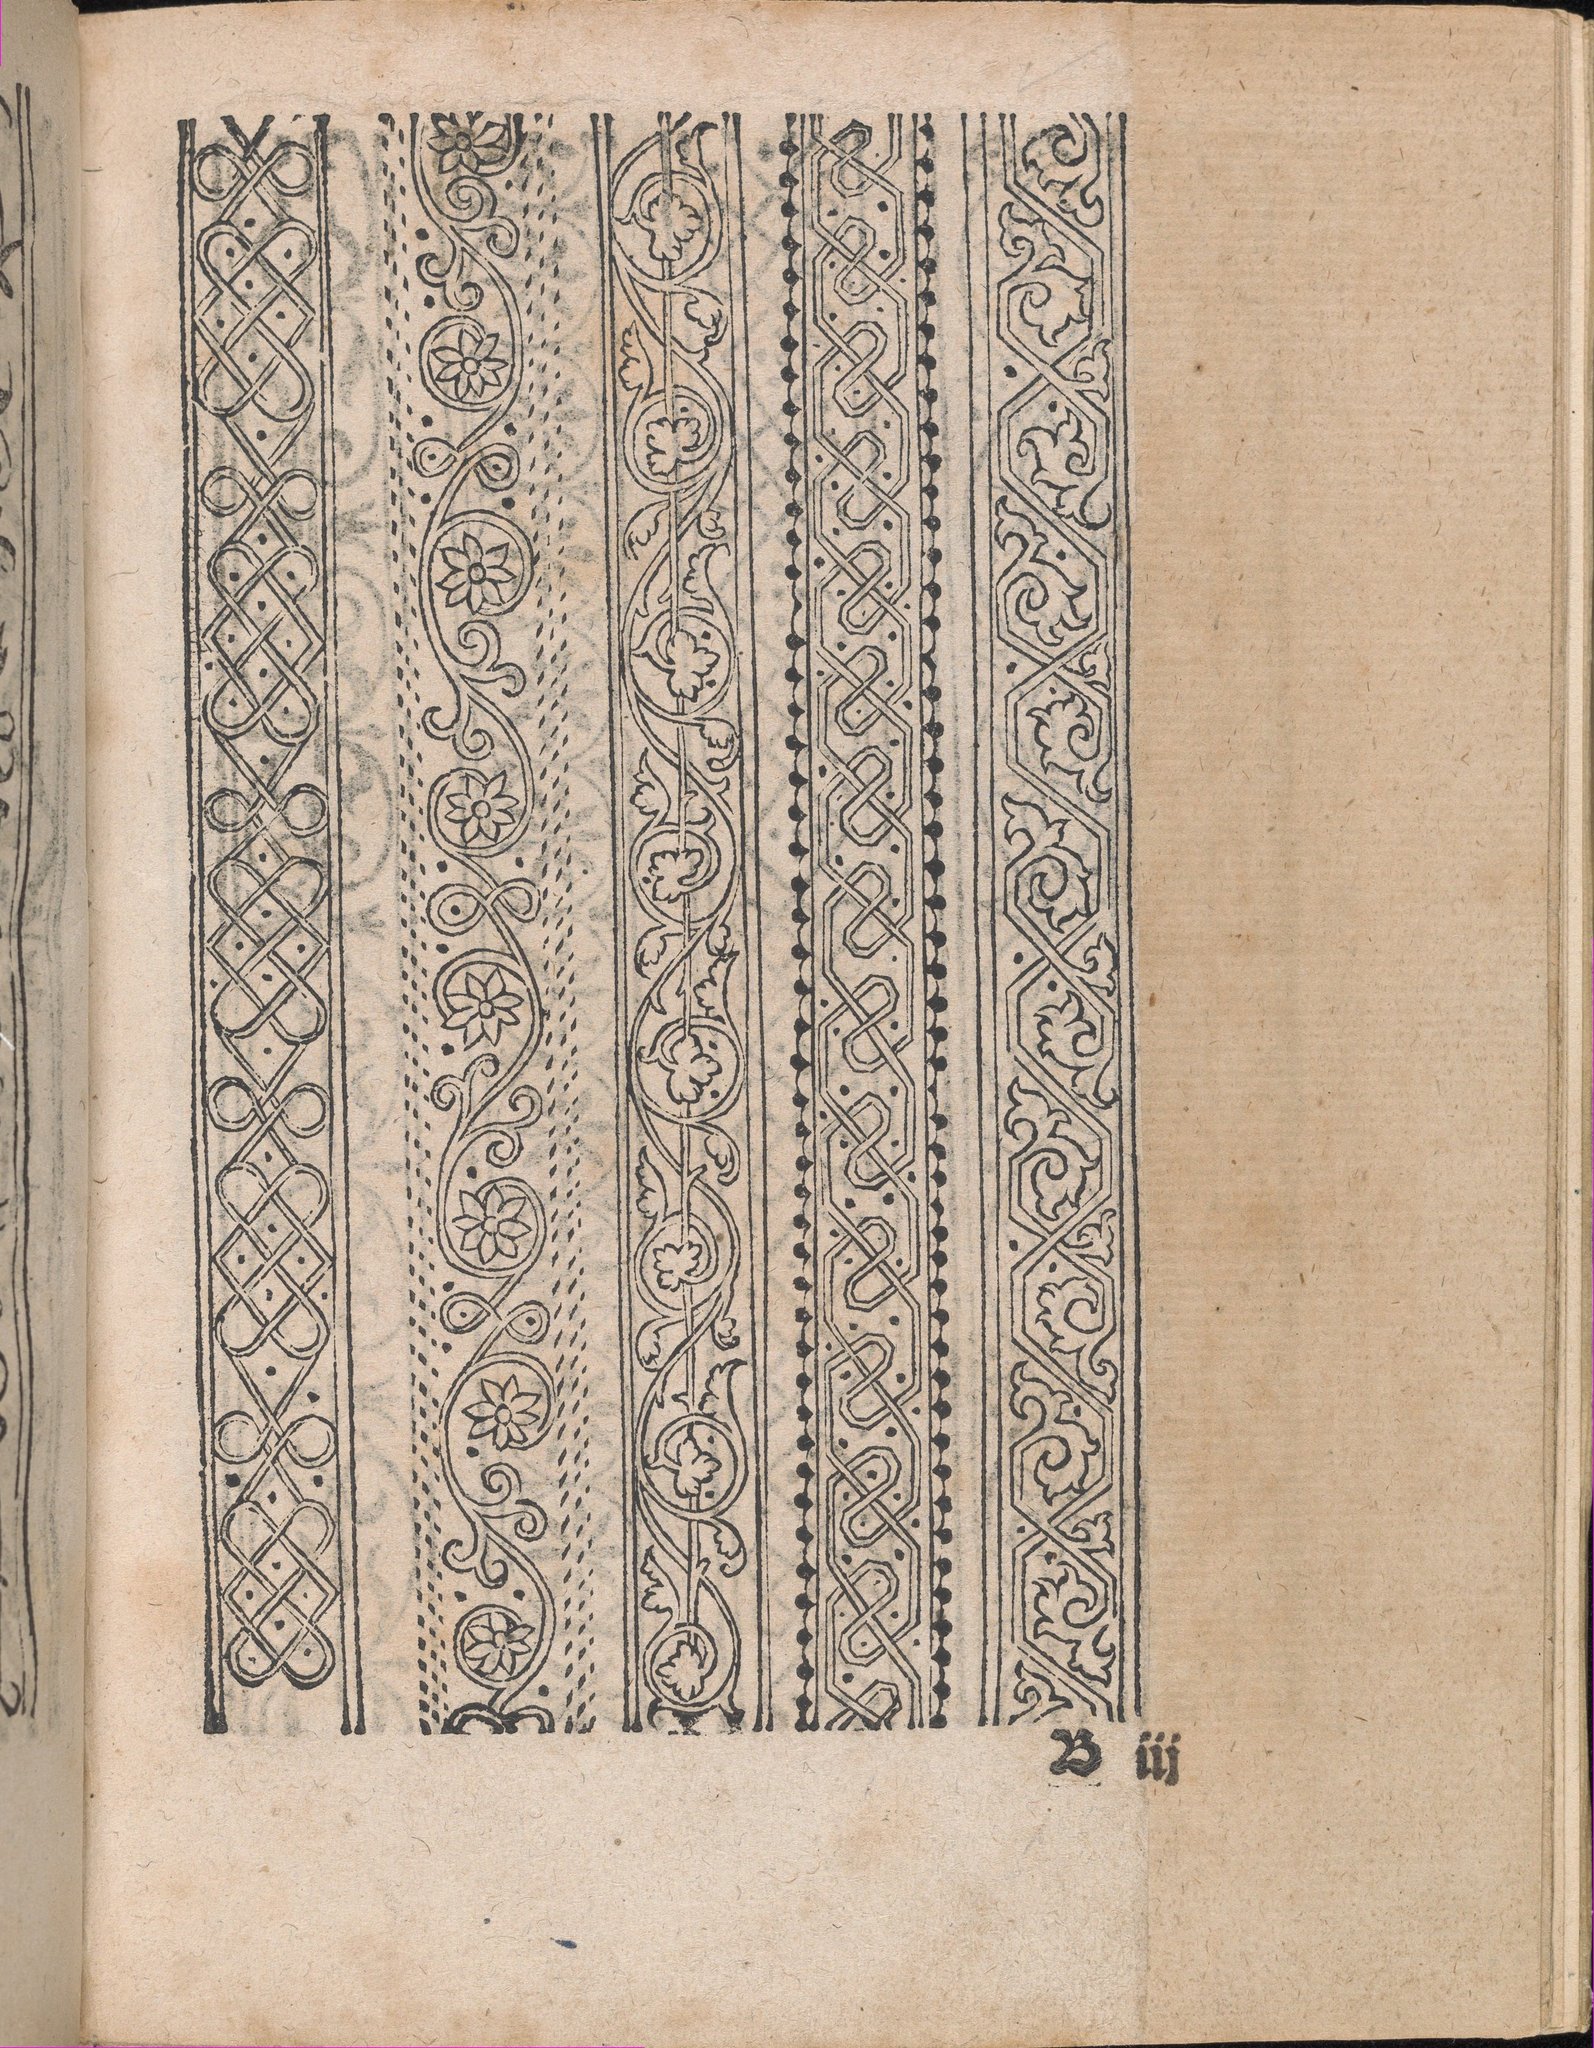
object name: book print ornament architecture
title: Modelbuch aller Art Nehens vn Stickens (Page 7r)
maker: christian egenolff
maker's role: publisher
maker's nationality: german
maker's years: 1502-1555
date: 1535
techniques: woodcut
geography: germany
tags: ornament,flowers